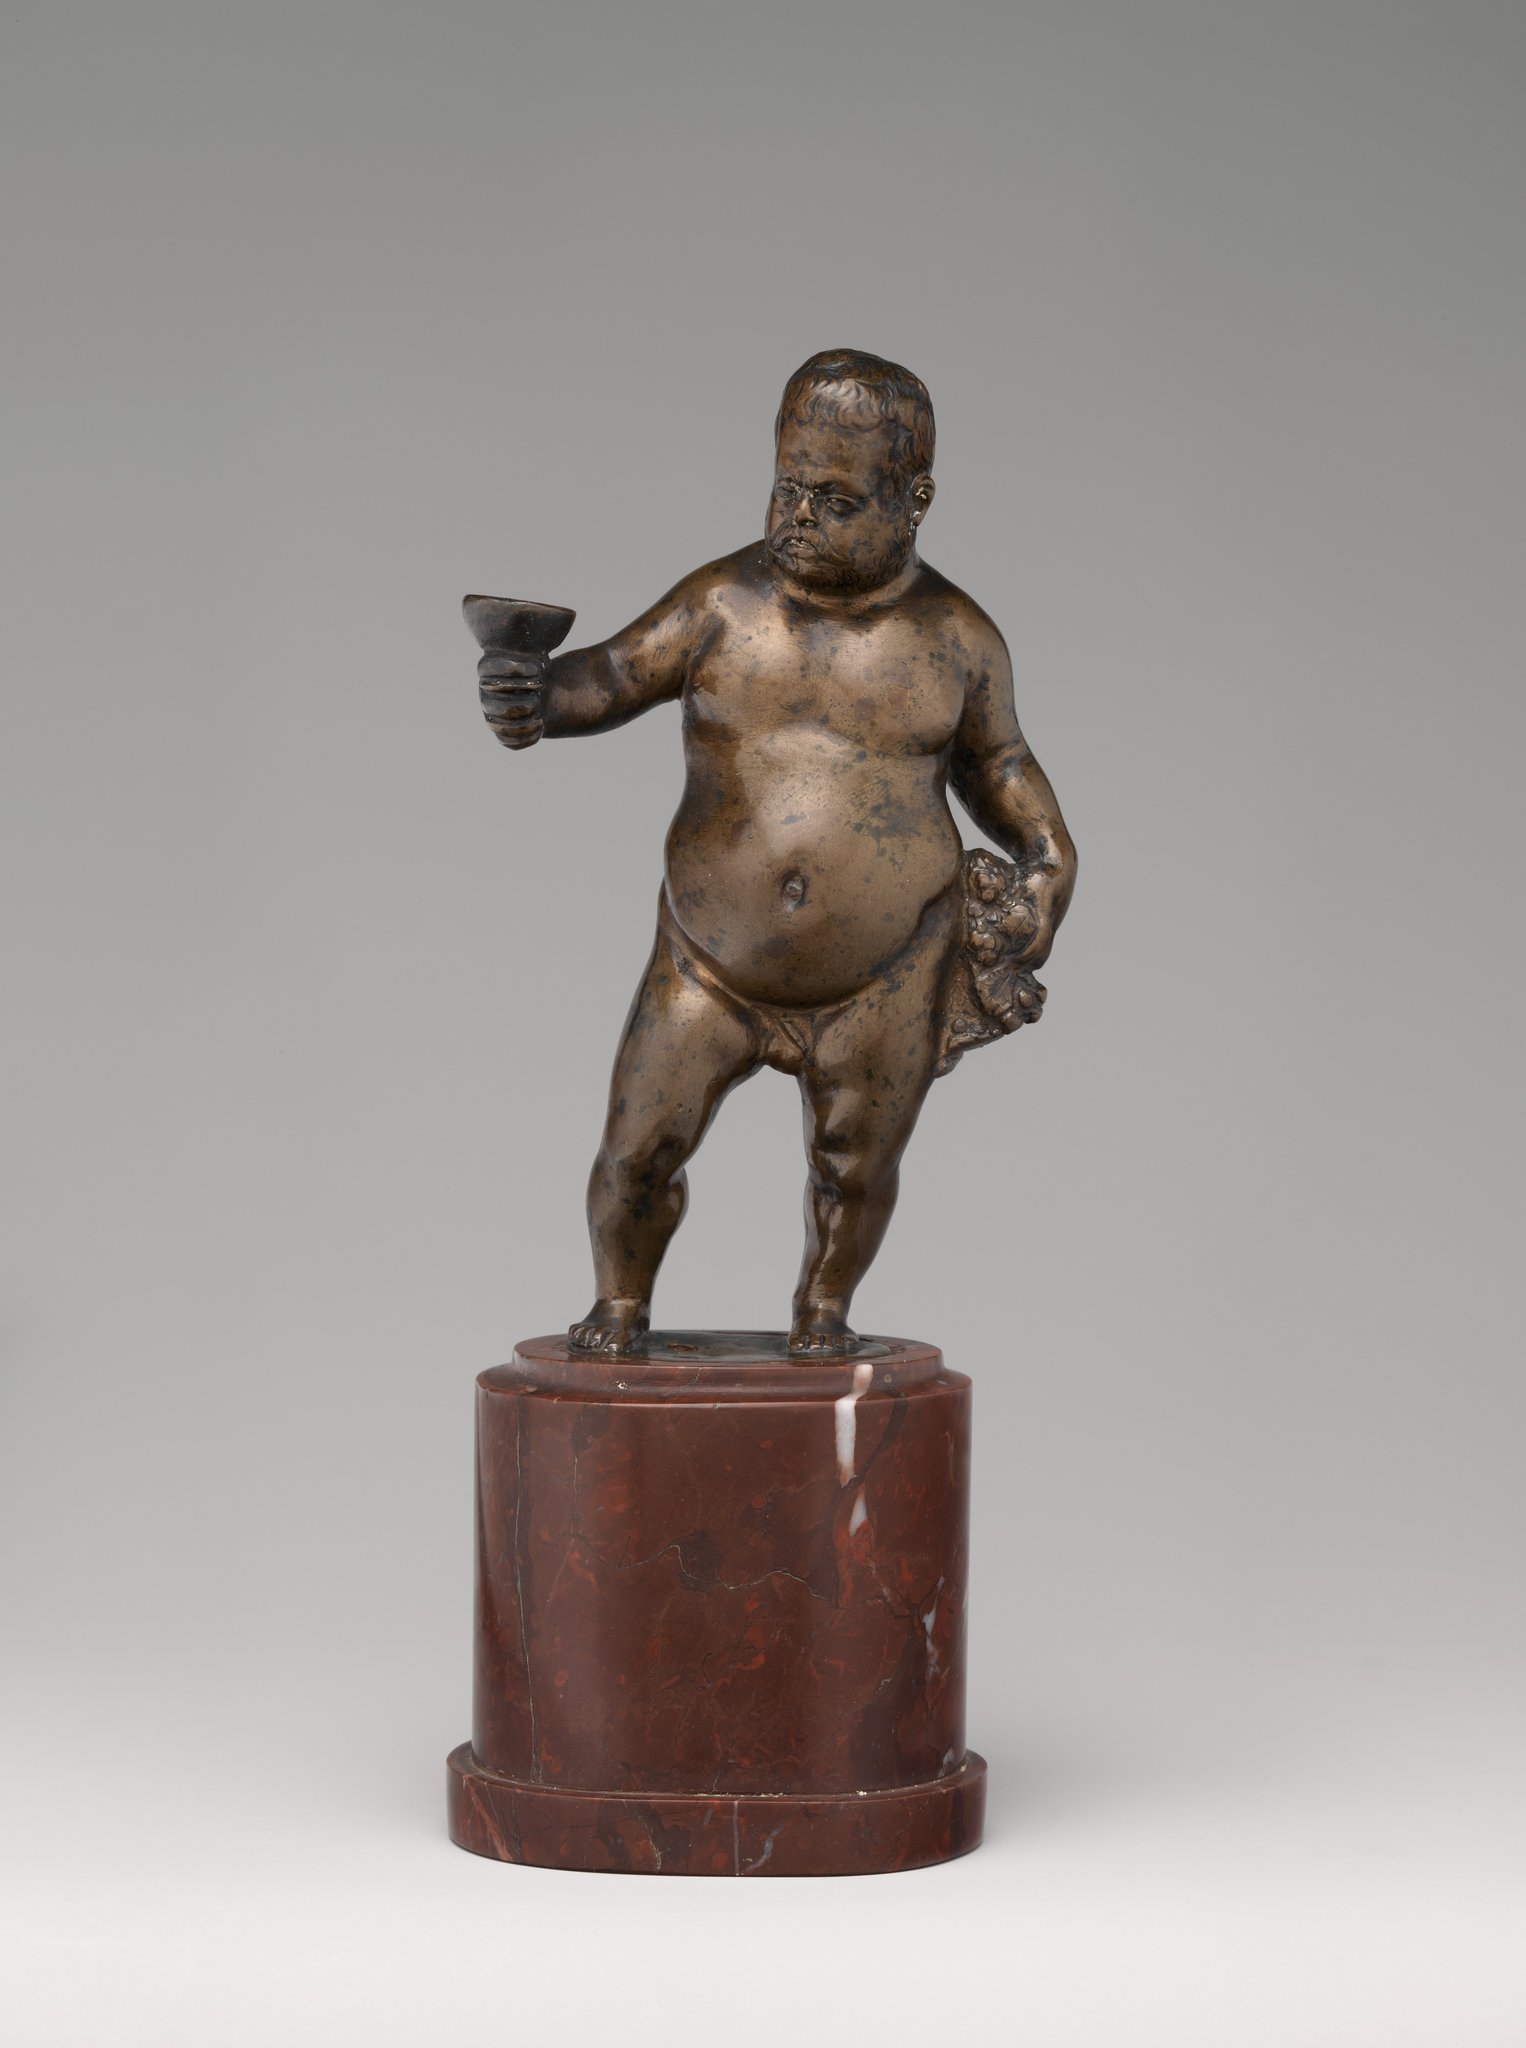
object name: statuette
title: The Dwarf Morgante as Bacchus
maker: giambologna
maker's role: artist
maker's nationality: netherlandish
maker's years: 1529-1608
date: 1601-1800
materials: bronze, marble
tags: male nudes